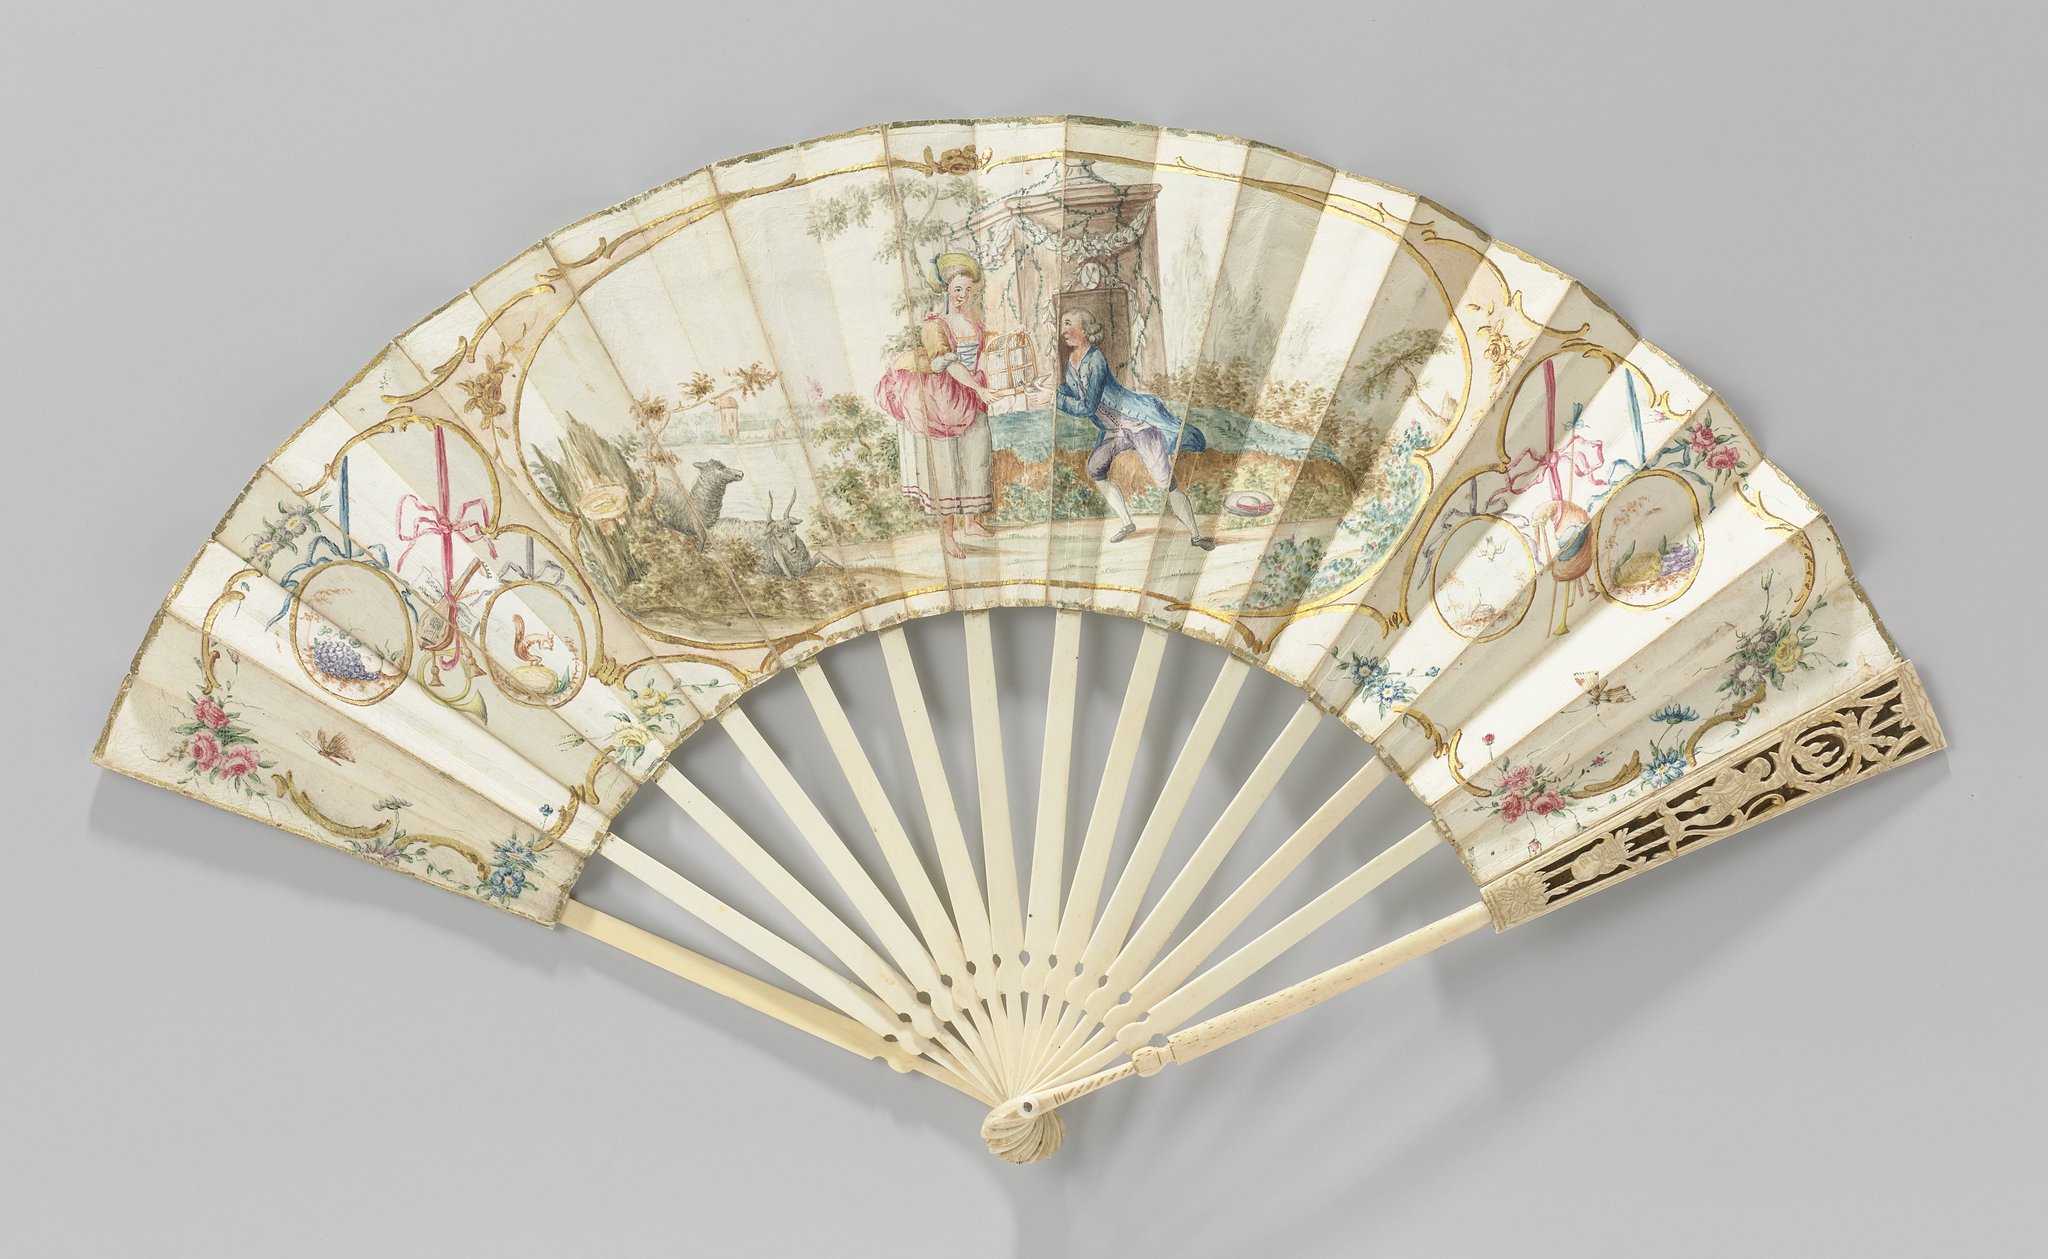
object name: vouwwaaier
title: Vouwwaaier met een pastorale scène, geflankeerd door ovale medaillons en muziekinstrumenten aan striklinten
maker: Anonymous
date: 1780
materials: bone, copper, paint, paper, watercolor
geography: netherlands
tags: johanna catharina adelaïde barones snouckaert van schauburg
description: Vouwwaaier met blad van papier waarop met aquarel en goudverf een pastorale scène is afgebeeld, geflankeerd door ovale medaillons en muziekinstrumenten een striklinten, op een open montuur van been. In de grote centrale cartouche geeft een zittende man een vogel aan een staande vrouw met een open vogelkooi. Het paar is voor een sokkel of klein bouwwerk geplaatst versierd met stenen guirlandes en groene bladslingers. Hierop is de voet van een vaas of bol te zien. Rechts van het paar een bossage, links een waterplas met op de achtergrond gebouwen en op de voorgrond twee schapen. Links van de centrale cartouche een ovaal medaillon - waarin een tros druiven en twee perziken - aan een groenblauw striklint, rechts een ovaal medaillon - waarin een eekhoorn op een meloen(?) - aan een violetkleurig striklint. Hier tussenin een snareninstrument, een blokfluit, bladmuziek, twee fluiten(?) en een hoorn aan een rozerood striklint. Onder dit geheel een grote libelle of vlinder. Rechts van de centrale cartouche een ovaal medaillon - waarin twee duiven met een nest vol eitjes - aan een violetkleurig striklint, uiterst rechts een ovaal medaillon - waarin ? - aan een groenblauw striklint. Hier tussenin een doedelzak, een herdersstaf, een trompet en een hoed aan een rozerood striklint. Onder dit geheel een grote libelle of vlinder. Op de achterkant van het blad is een klassieke vaas geschilderd. Het montuur heeft twaalf gladde benen; alleen de sluitbenen zijn versierd. Hierop een gestapeld ornament met van beneden naar boven: een (zonne?)bloem, een dodelzak en bloemenmand, een dansende man, twee brandende harten in een dubbele lauwerkrans waarop twee pijlenkokers liggen onder brandende toortsen. Koperen sluitpin.